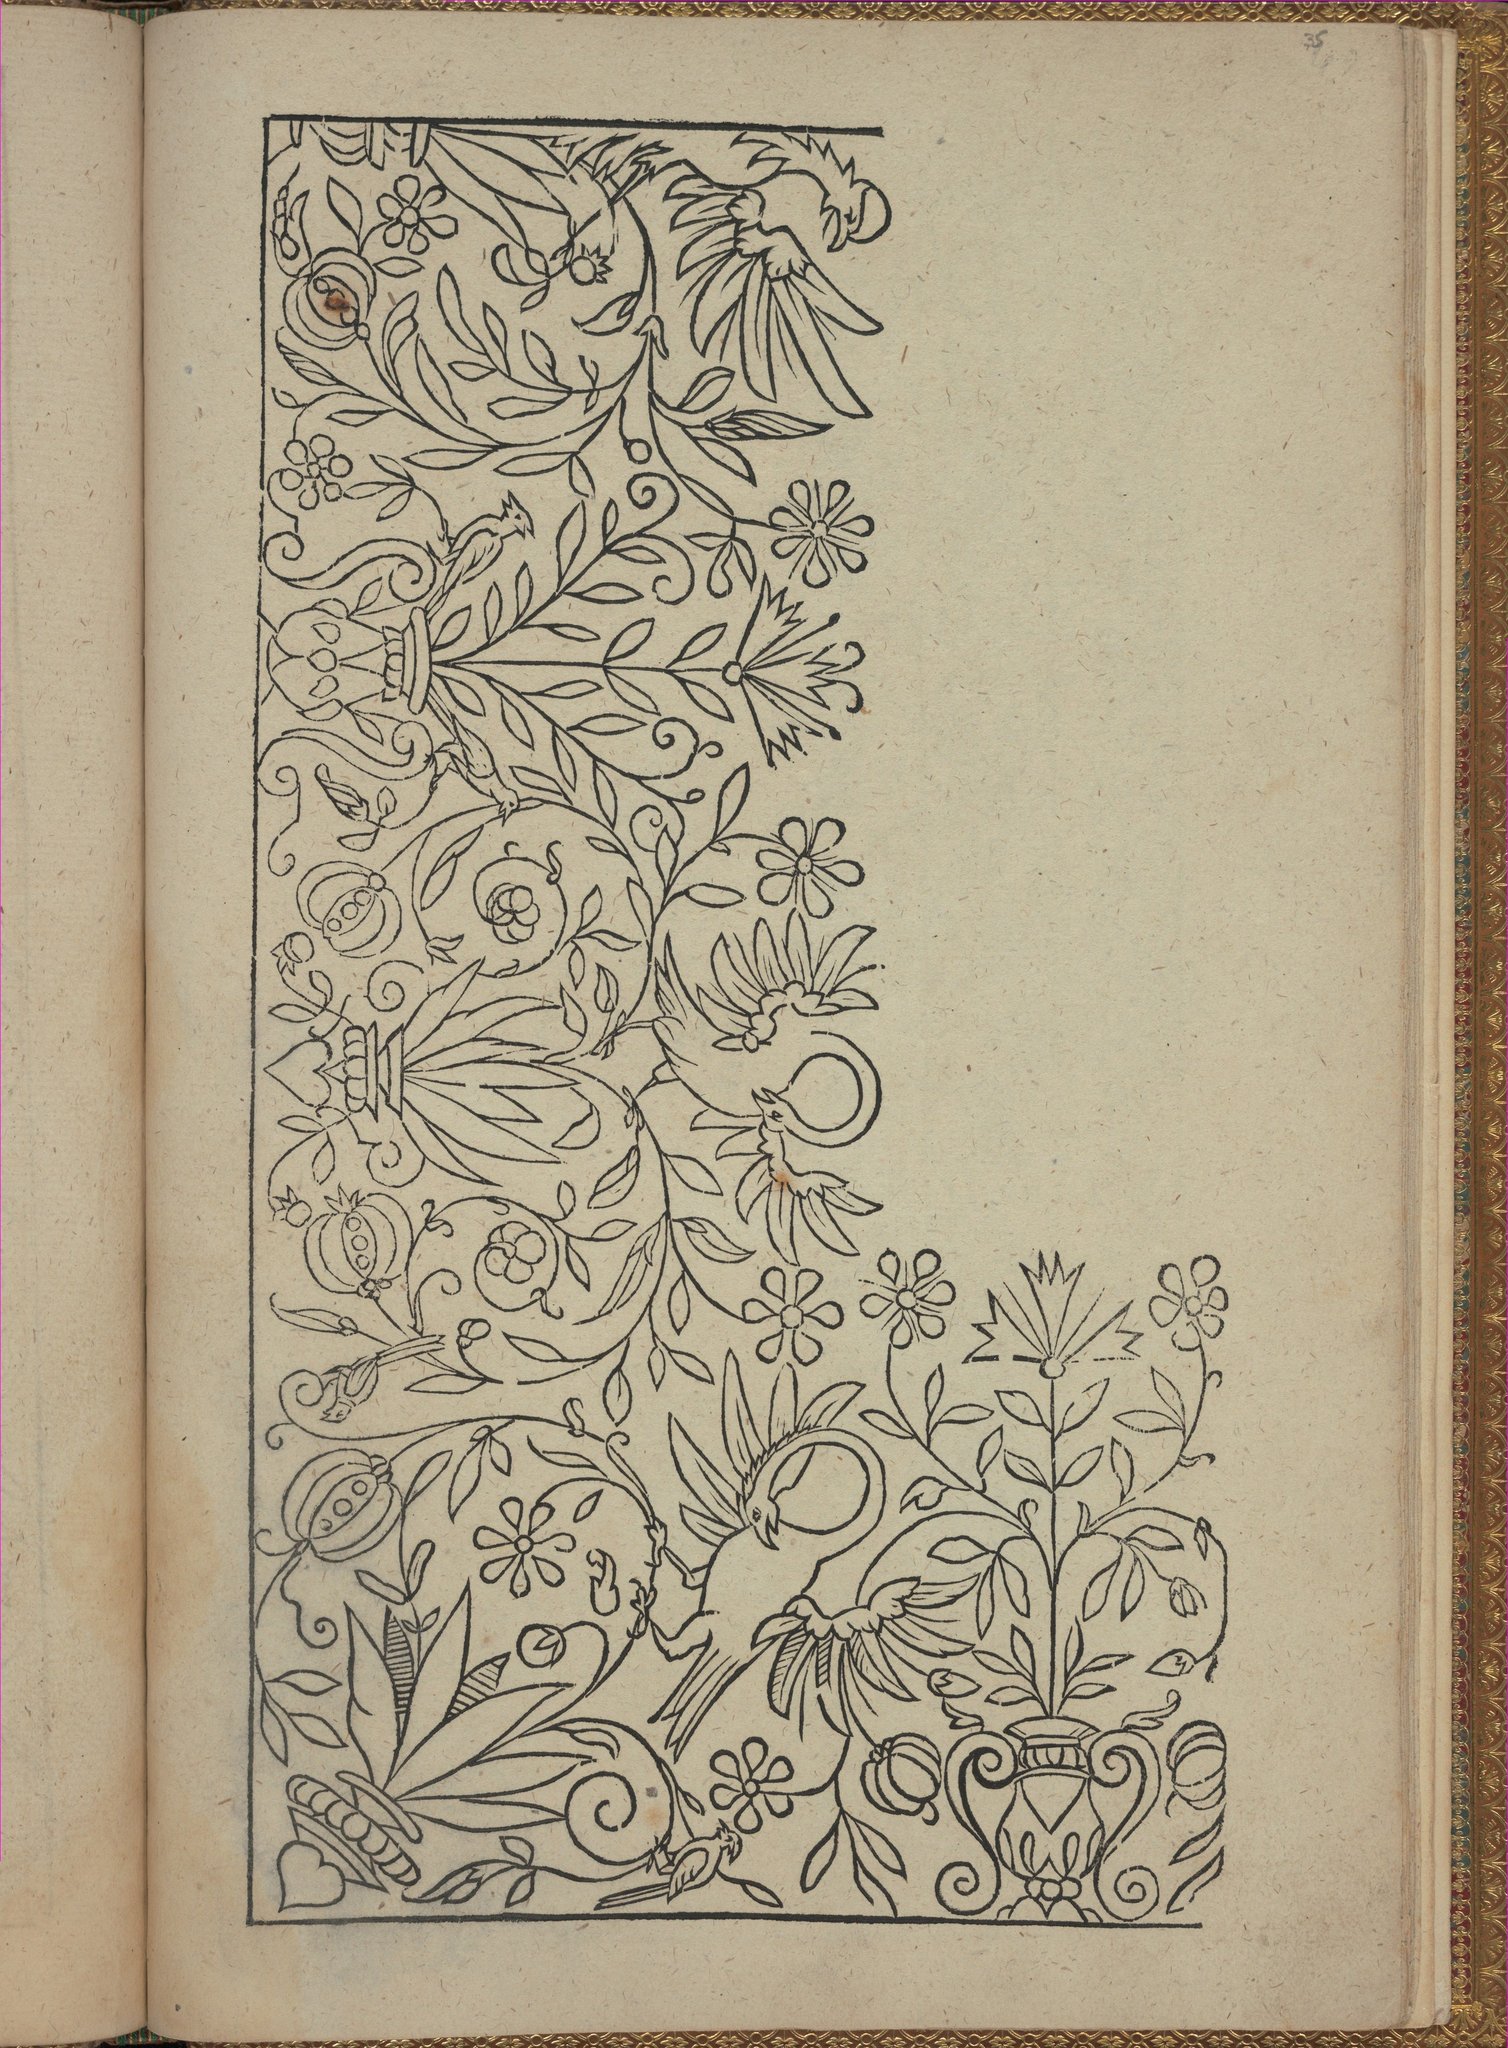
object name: book print ornament architecture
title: New Modelbüch (Page 35r)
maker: andreas bretschneider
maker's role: designer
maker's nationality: german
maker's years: 1573-1645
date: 1615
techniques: woodcut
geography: germany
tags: birds,flowers